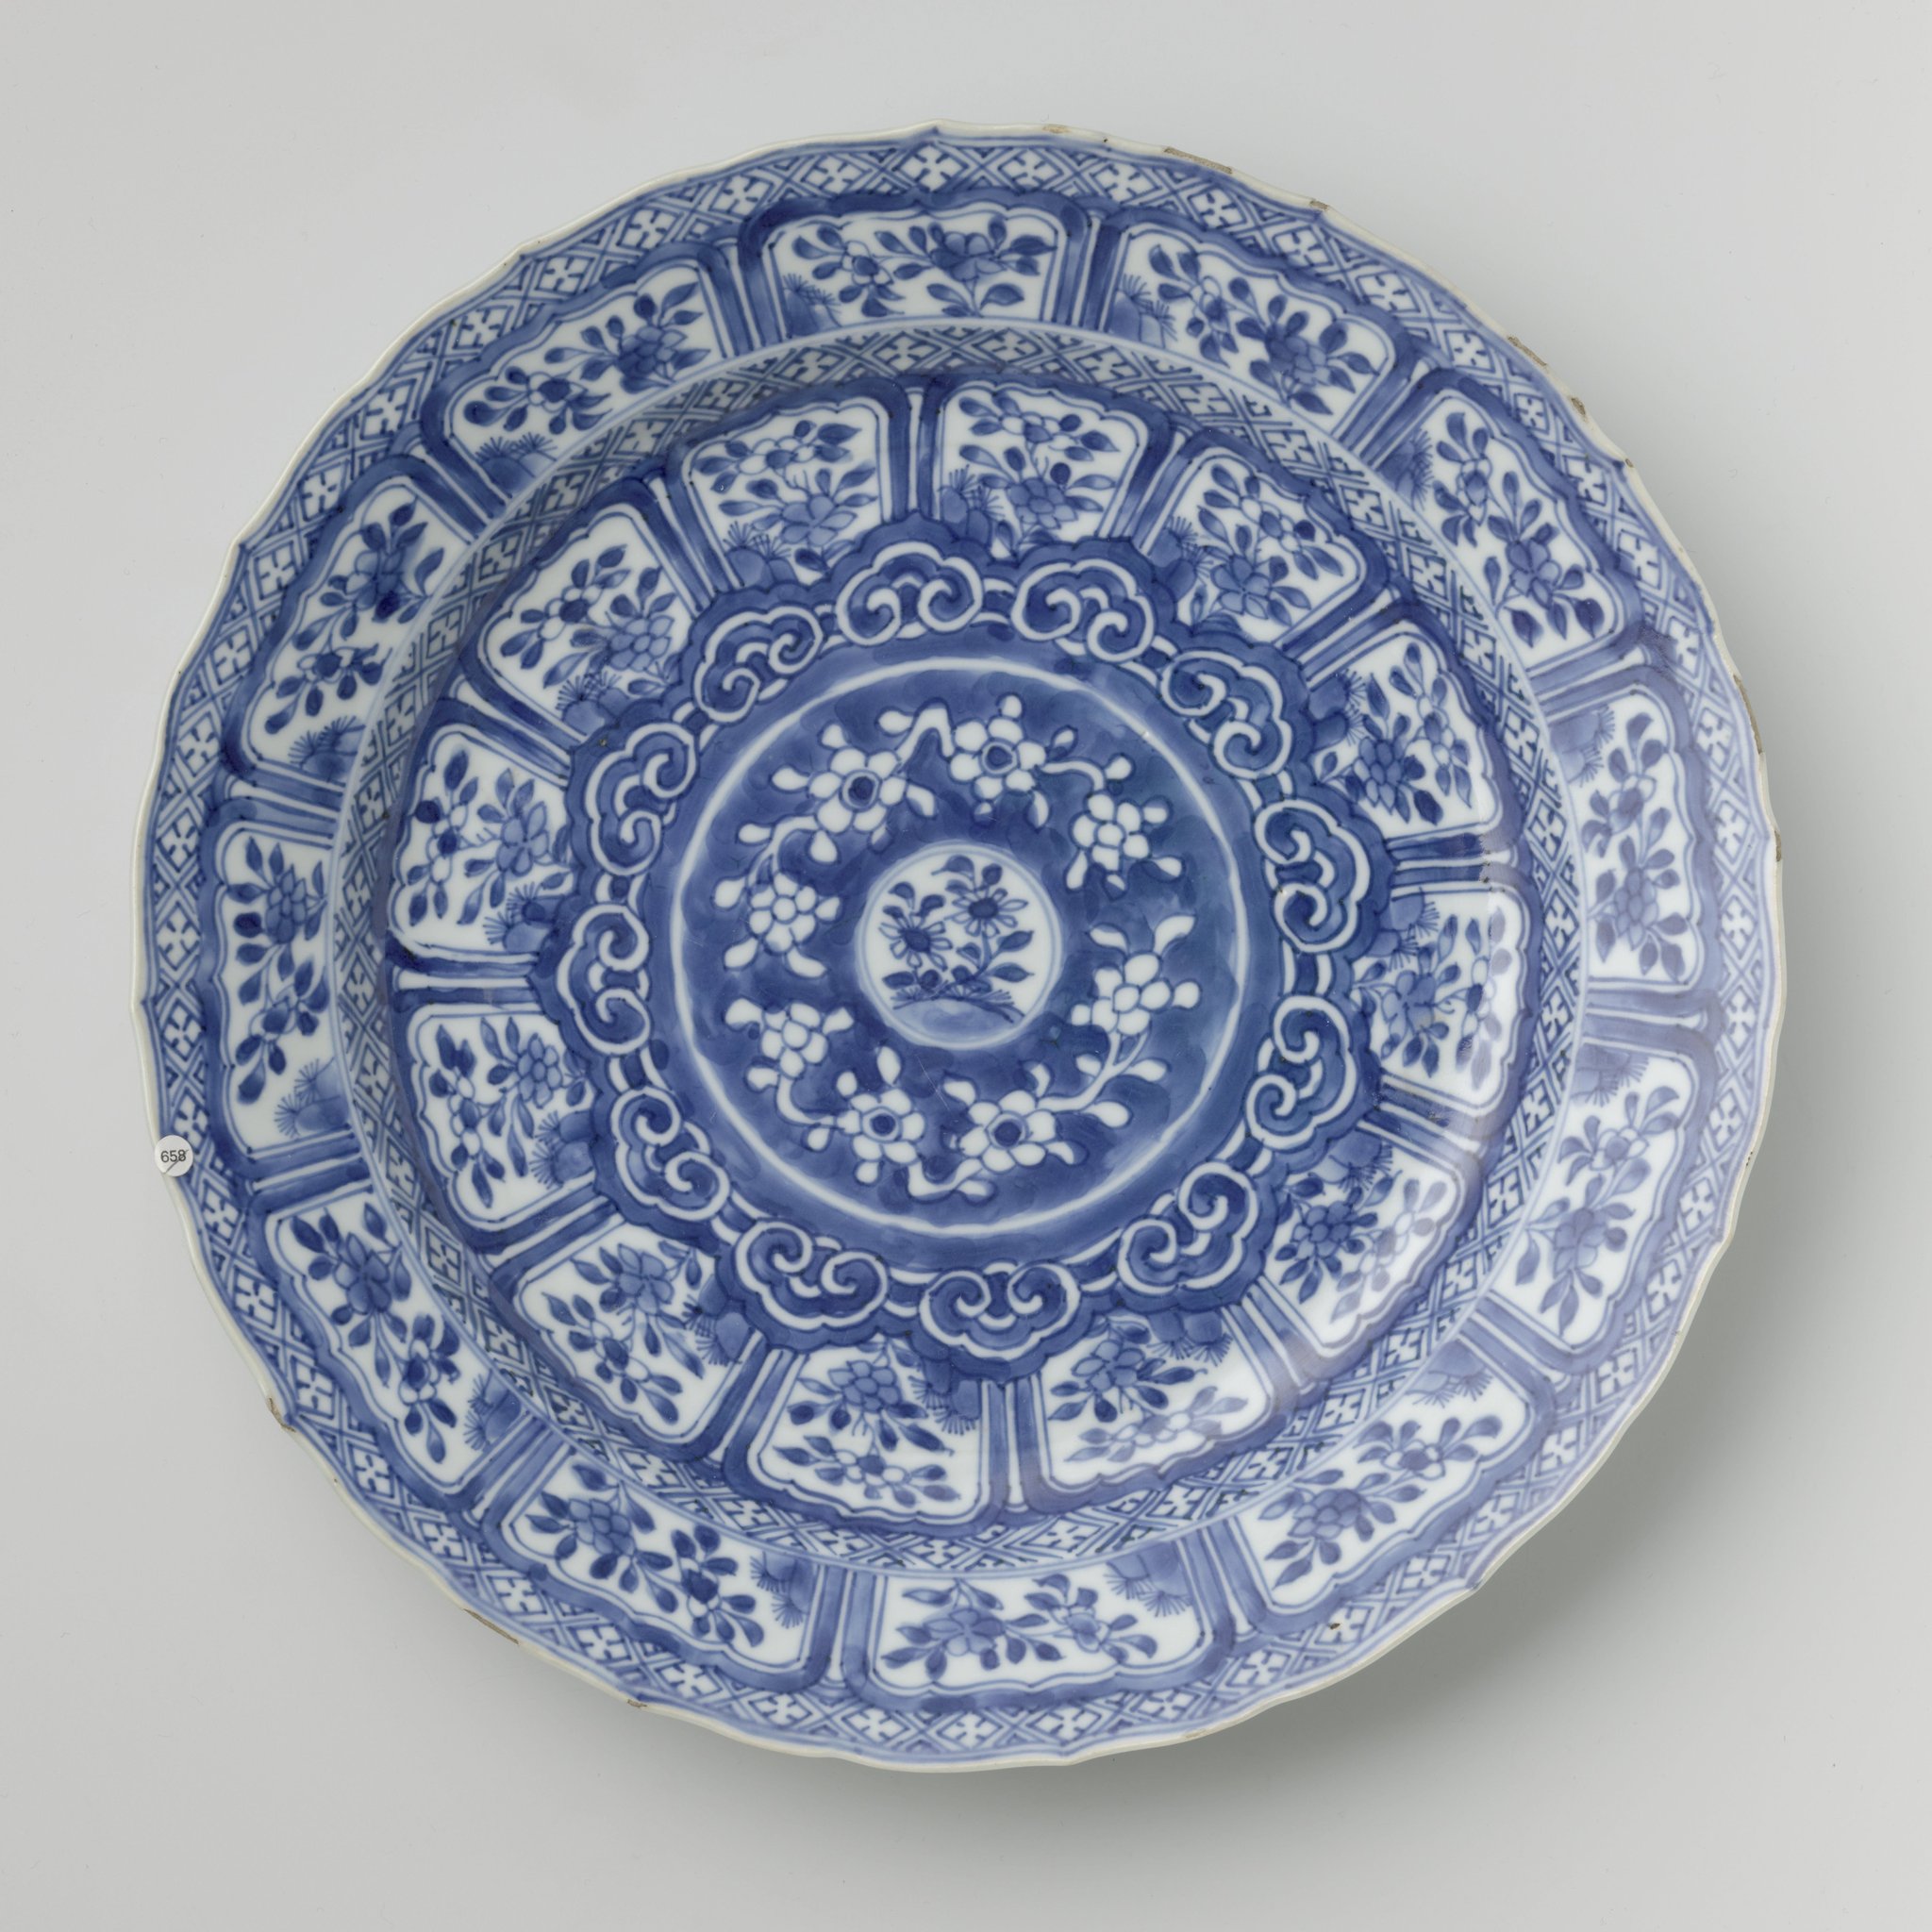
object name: platter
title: Dish with medallion surrounded by ornamental borders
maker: Anonymous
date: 1700-1724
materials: cobalt, glaze, paint, porcelain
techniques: firing, turning, vitrification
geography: china